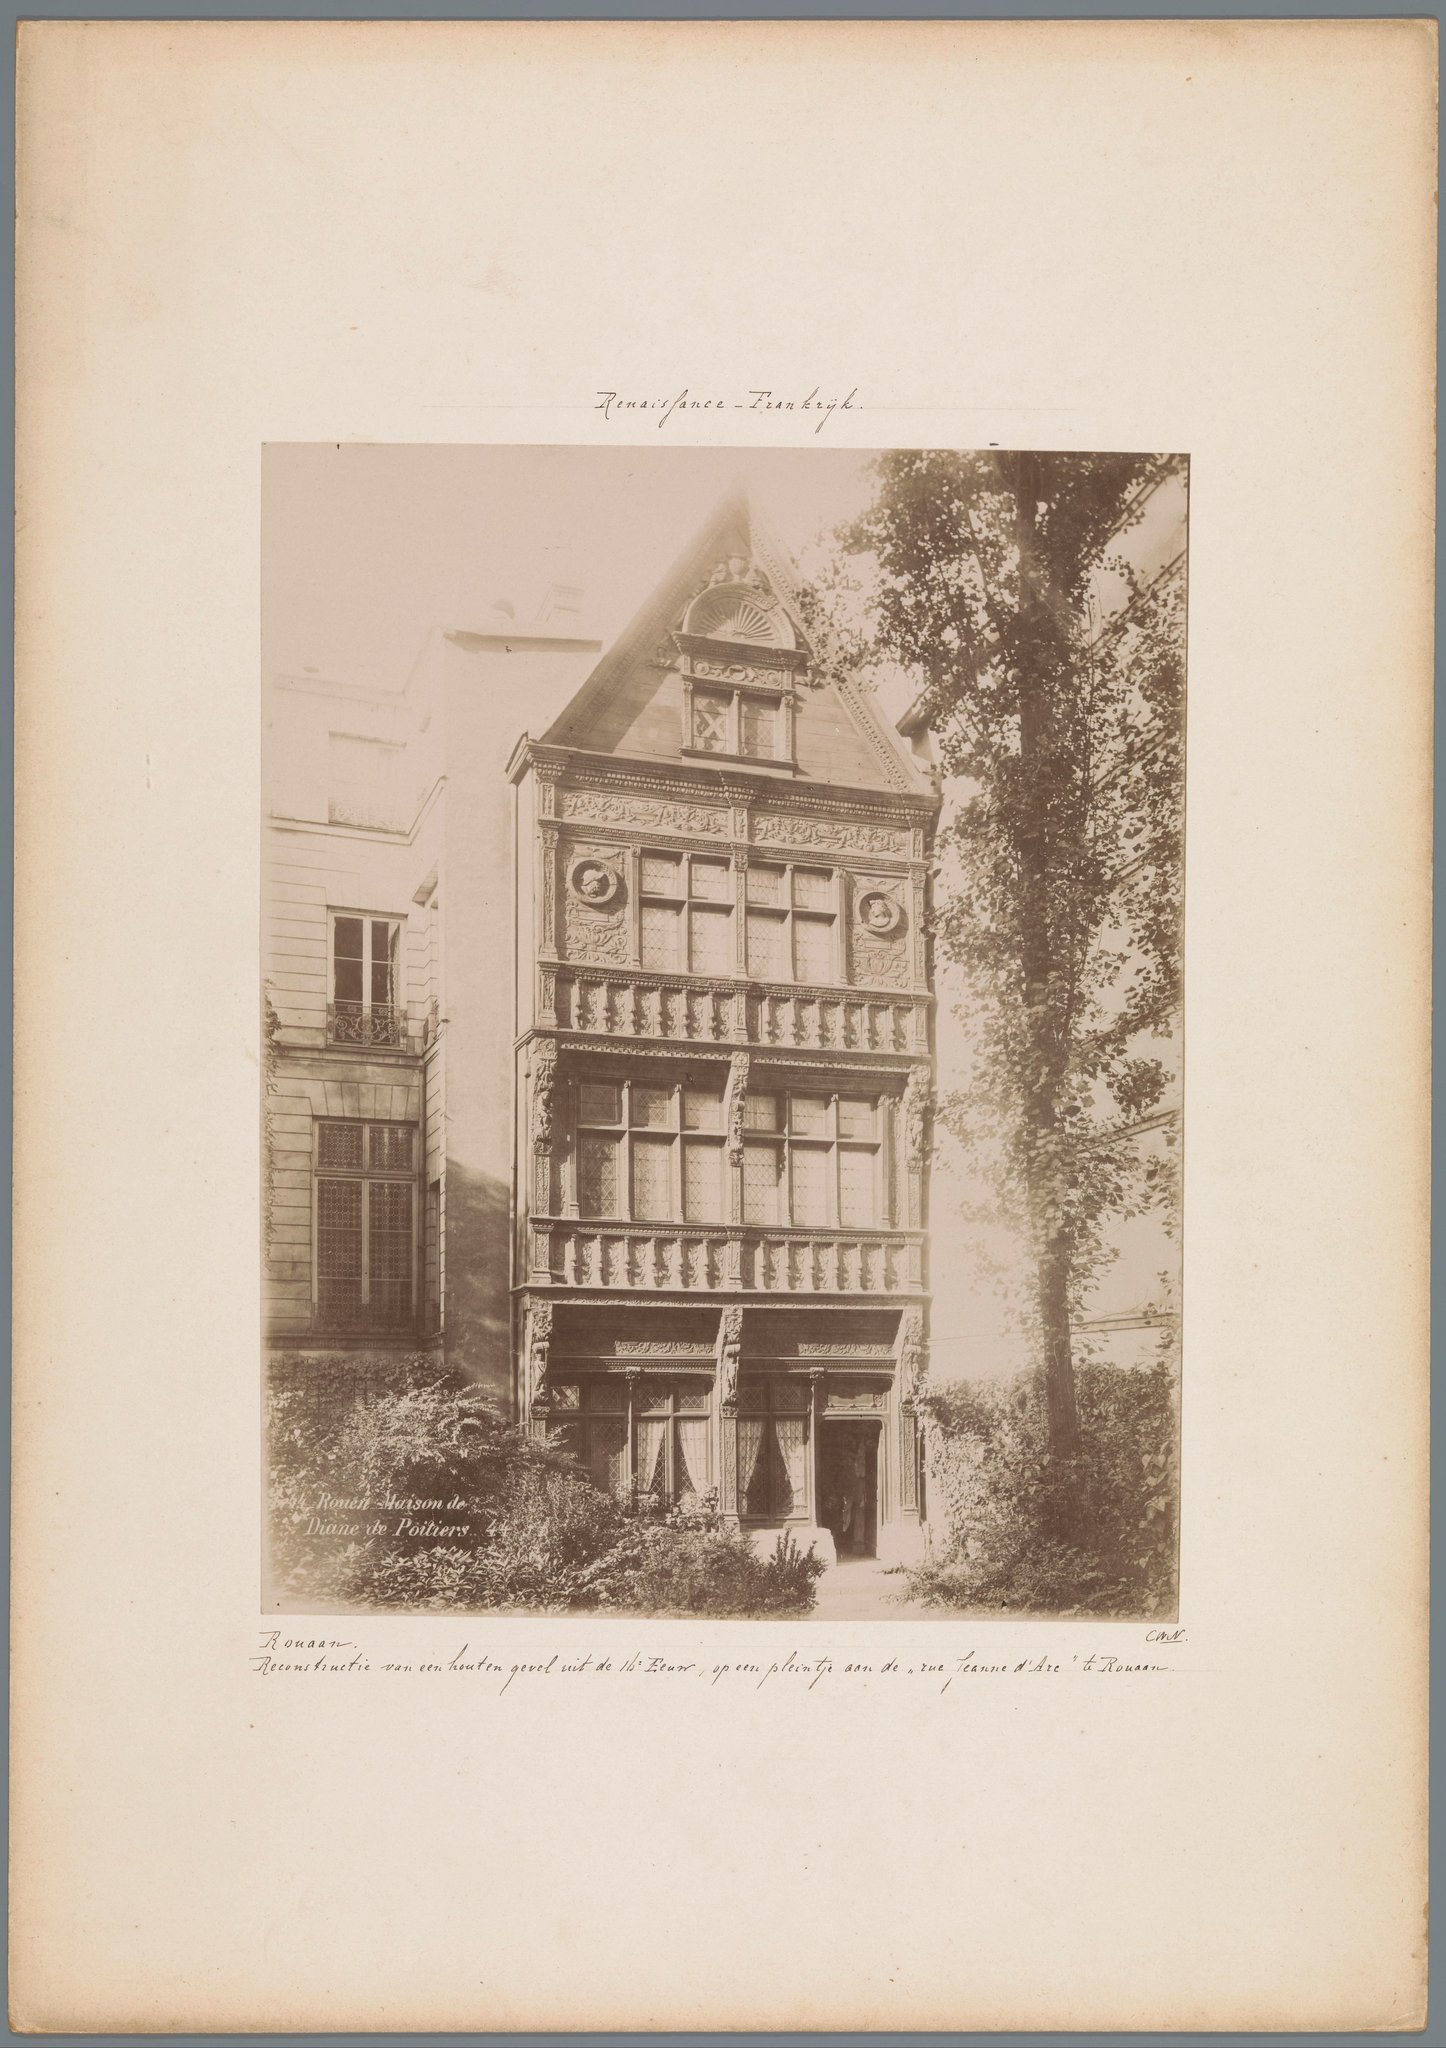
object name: photograph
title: Rouen Maison de Diane de Poitiers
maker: Anonymous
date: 1875-1900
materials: cardboard, photographic support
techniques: albumen print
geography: rouen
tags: housing, exterior ~ representation of a building, façade (of house or building), sculpture (+ relief ~ sculpture)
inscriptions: inscription: ‘Renaissance - Frankrijk. Rouaan. Reconstructie van een houten gevel uit de 16e Eeuw, op een pleintje aan de ,,rue Jeanne d'Arc'' te Rouaan.’, collector's mark: ‘KUNSTNIJVERHEIDSCHOOL QUELLINUS AMSTERDAM FRANS HALSSTRAAT 14.’, collector's mark: ‘INSTITUUT VOOR KUNST- NIJVERHEIDSONDERWIJS GABRIËL METSUSTRAAT No. 16. AMSTERDAM’, inscription: ‘CWN.’, number: ‘44’